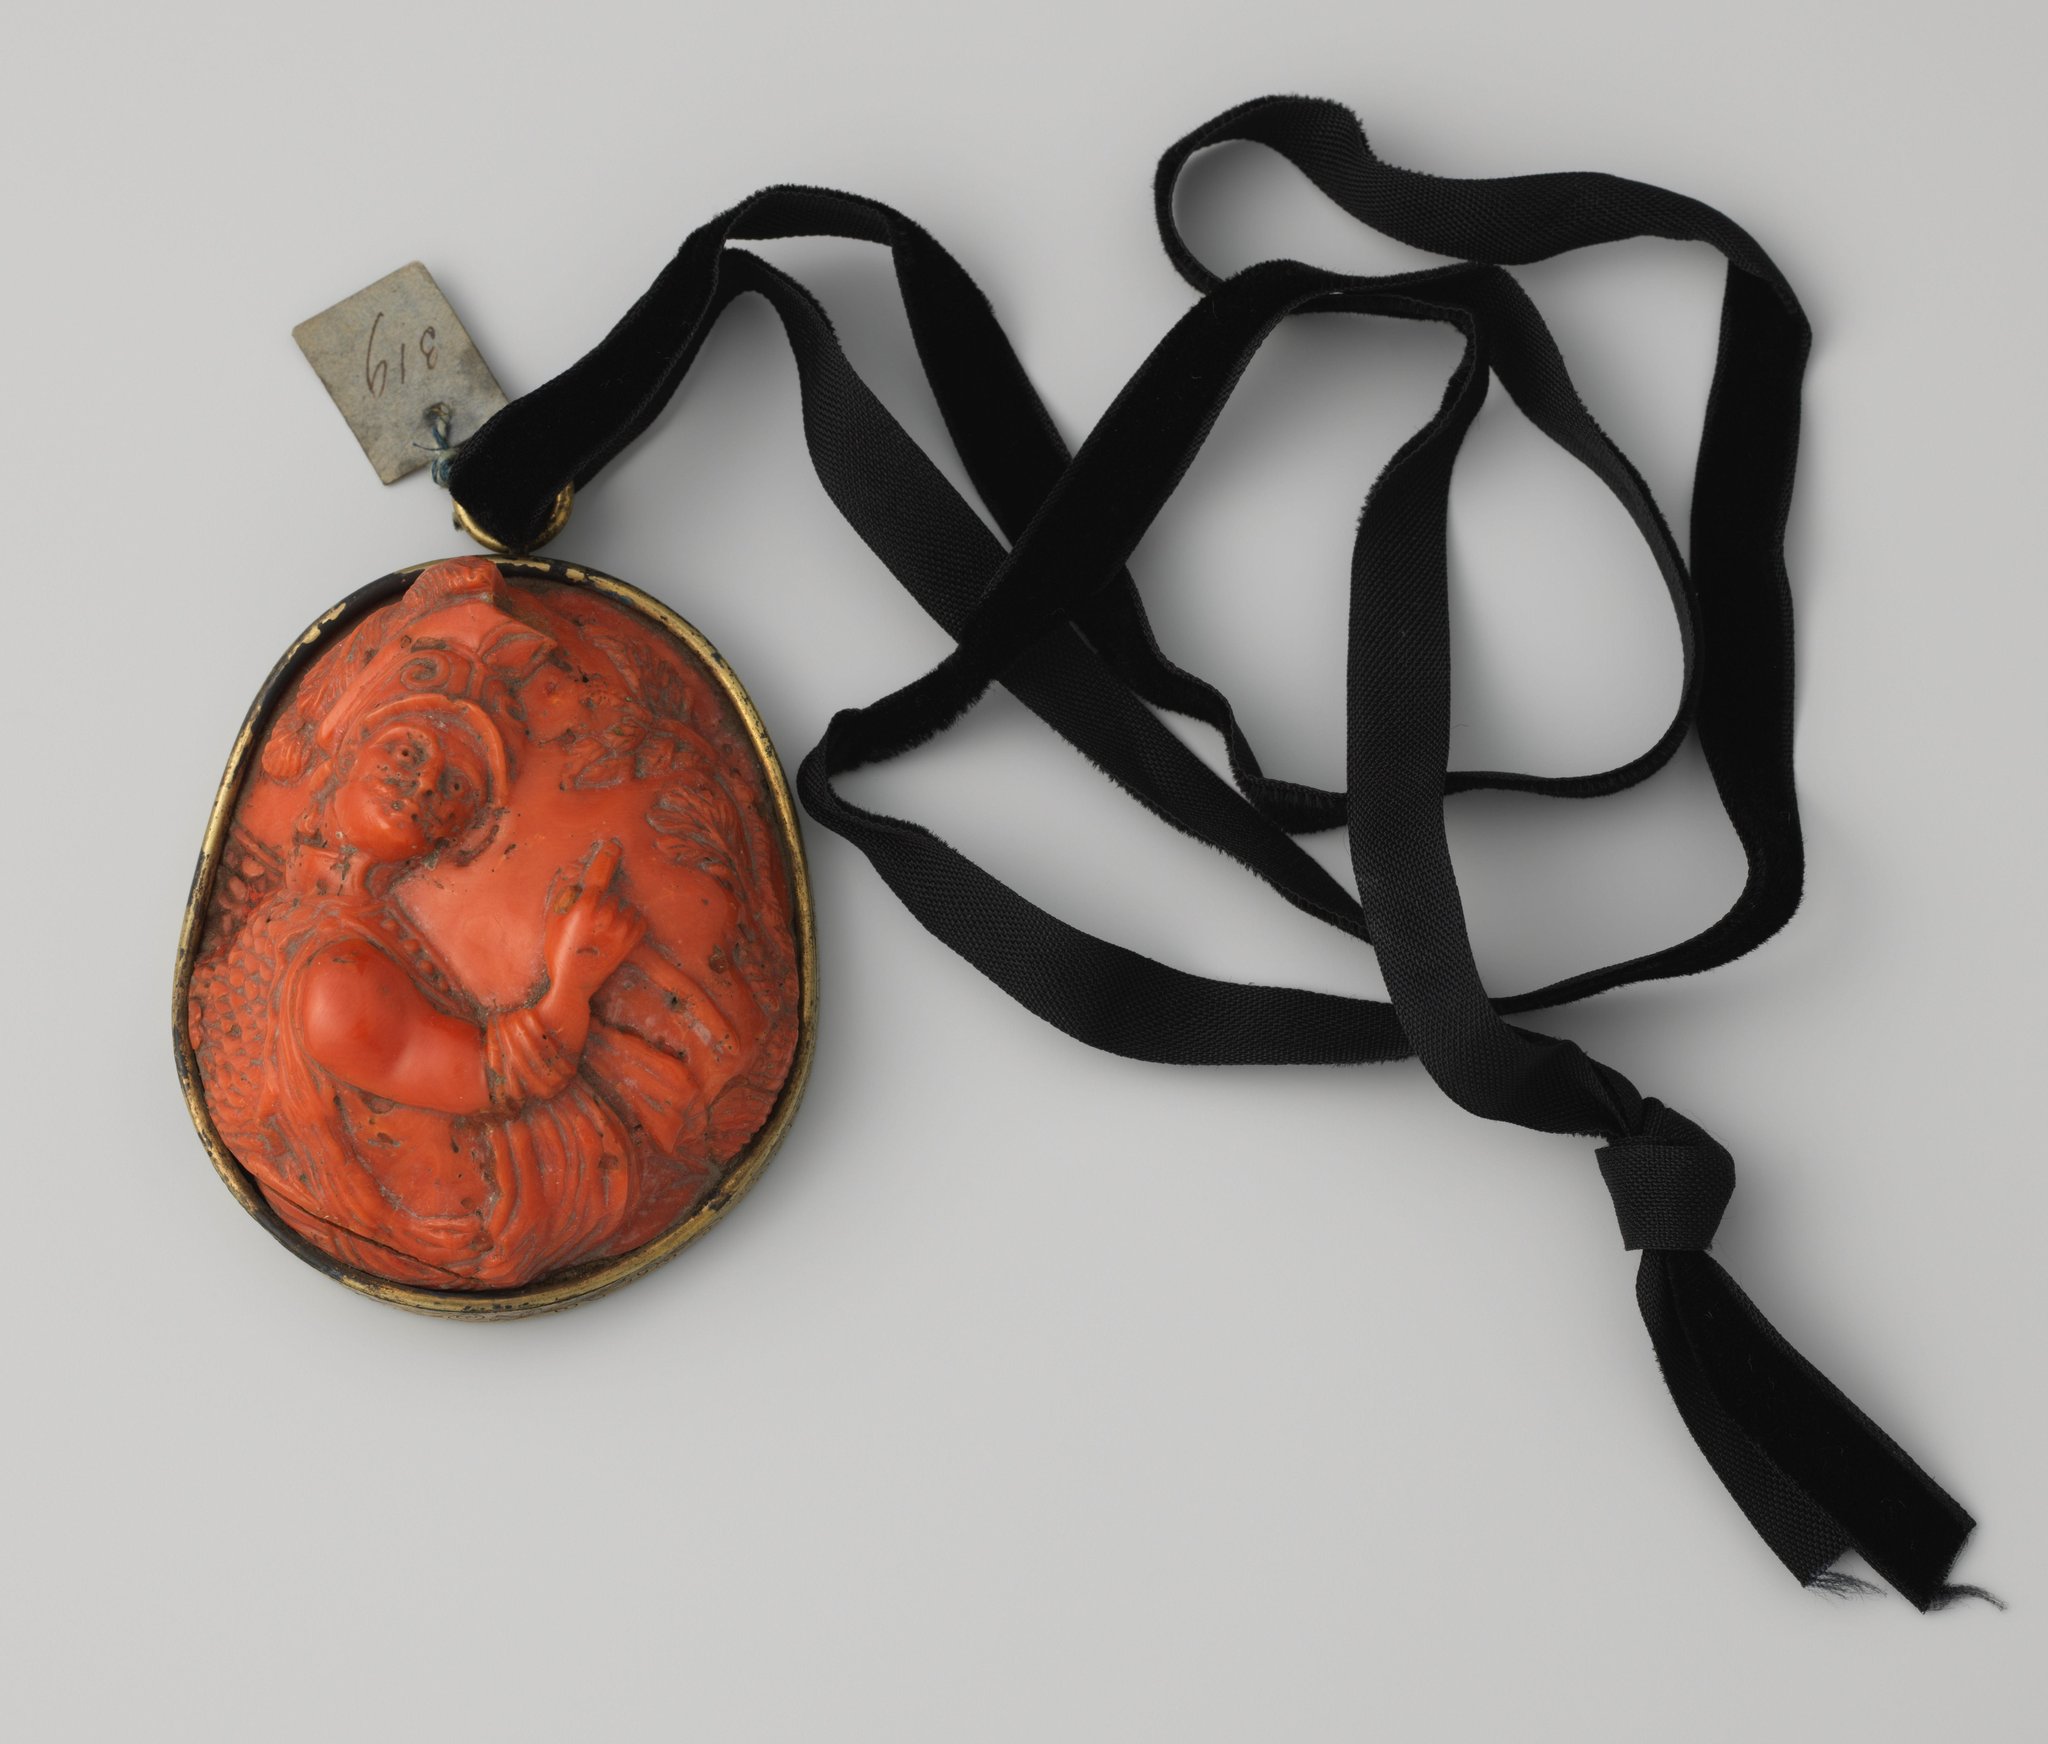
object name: locket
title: Medaillon met gesneden voorstelling van een Romeinse soldaat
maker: Anonymous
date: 1400-1950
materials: copper, coral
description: Medaillon van bloedkoraal met gesneden voorstelling van een Romeinse soldaat. In koper gevat met gesneden rococo-ornamenten. Het medaillon hangt aan een zwart lint.